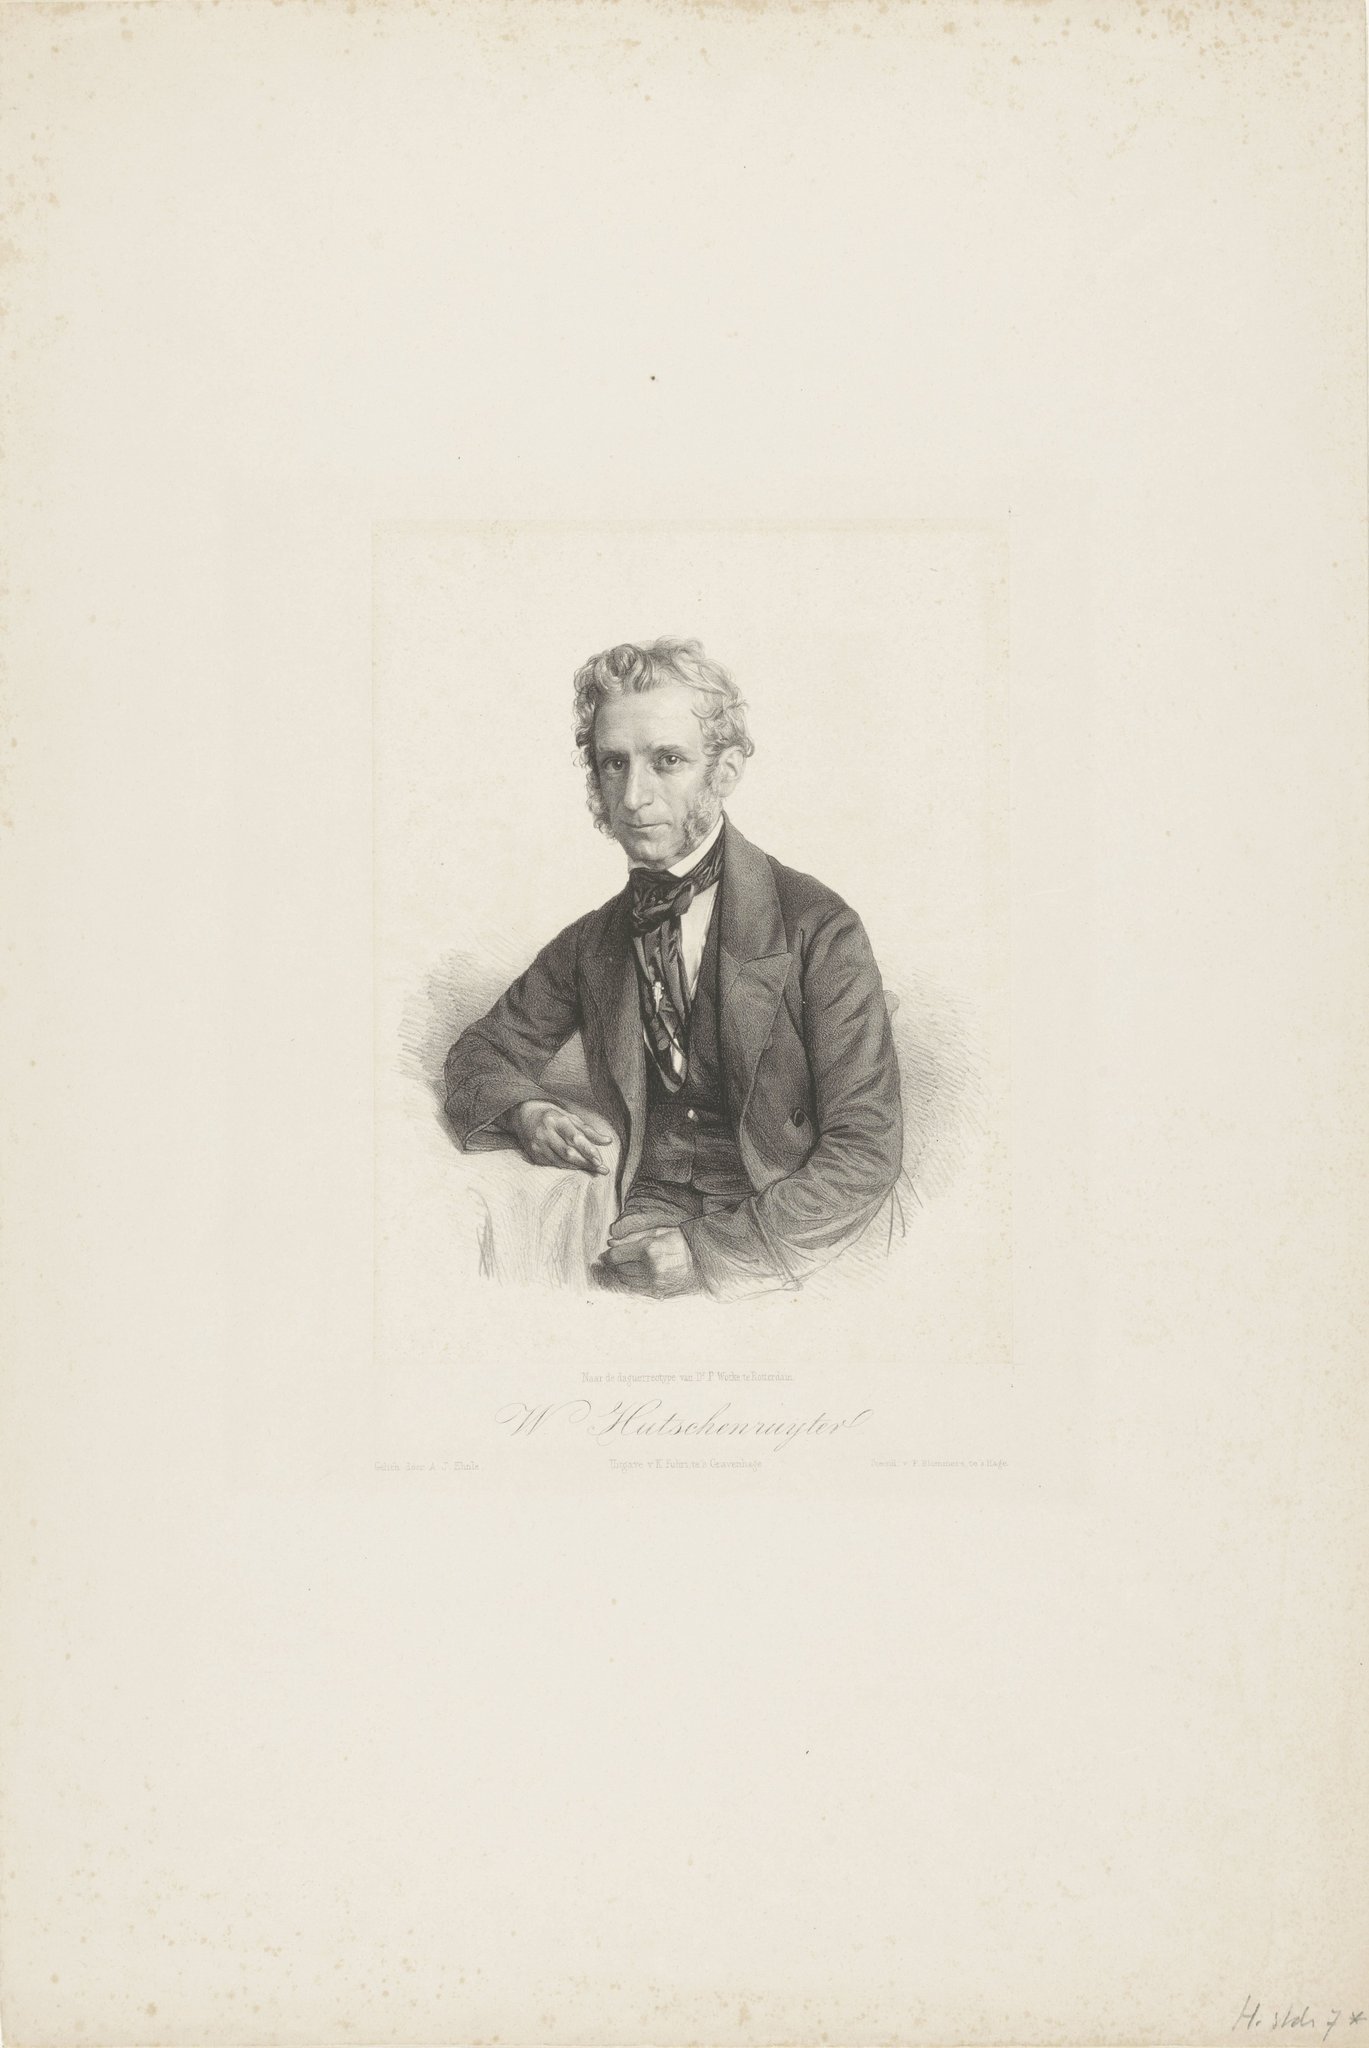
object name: print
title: Portret van Wouter Hutschenruyter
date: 1855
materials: paper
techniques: lithograph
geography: the hague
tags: historical persons (+ (full) bust portrait)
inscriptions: collector's mark: Lugt 2228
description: De geportretteerde zit aan een tafel en hij draagt een das met een speld. Onder het portret zijn naam. Onderdeel van een serie van twaalf portretten naar daguerrotypieën en twaalf stadsgezichten. Ter gelegenheid van het Muziekfeest ter viering van het 25-jarige bestaan van de Maatschappij ter Bevordering van Toonkunst in Rotterdam, 12-15 juli 1854.